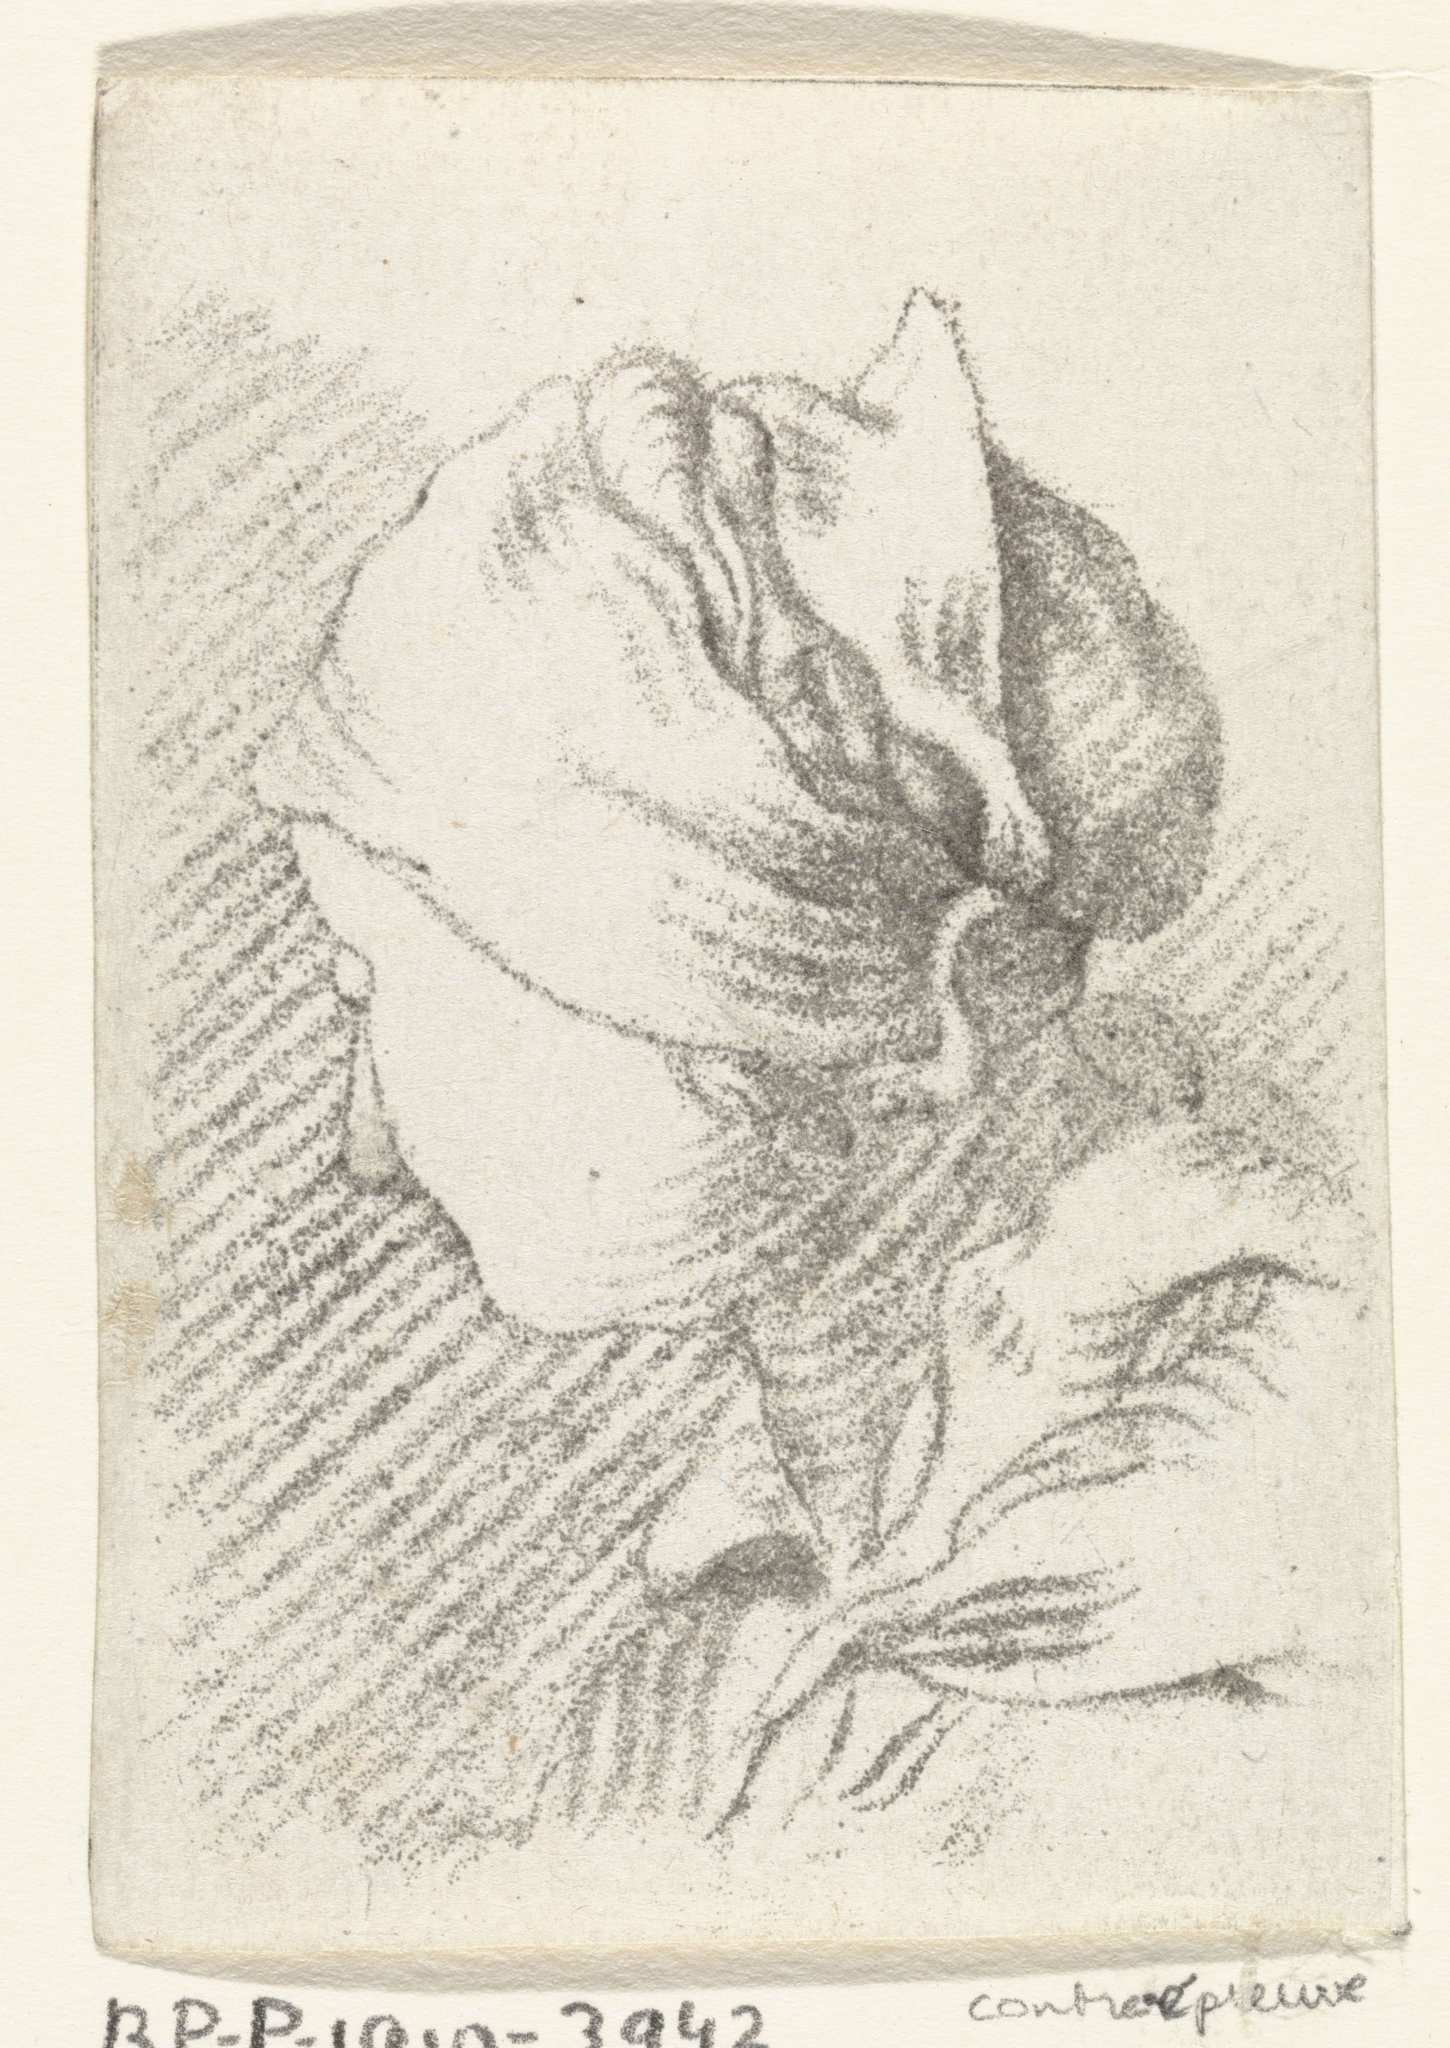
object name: print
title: Vrouwenbuste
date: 1739-1851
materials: paper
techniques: printmaking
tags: head-gear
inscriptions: collector's mark: Lugt 2228